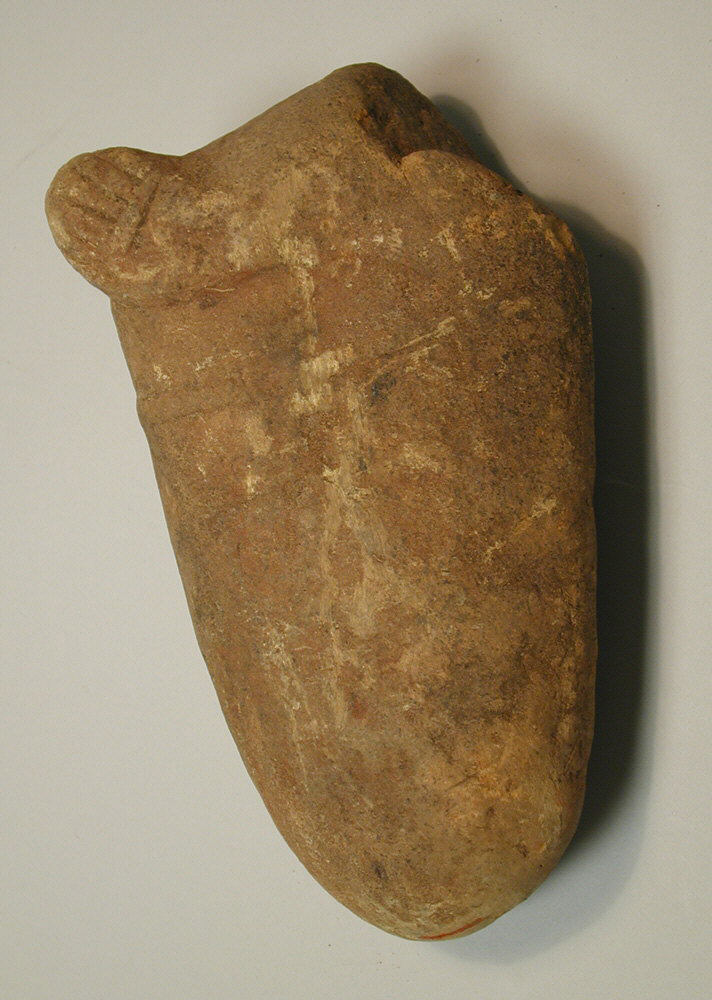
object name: figure fragment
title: Fragment of a Zoomorphic Figure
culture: southern highlands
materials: pigment, stone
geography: papua new guinea